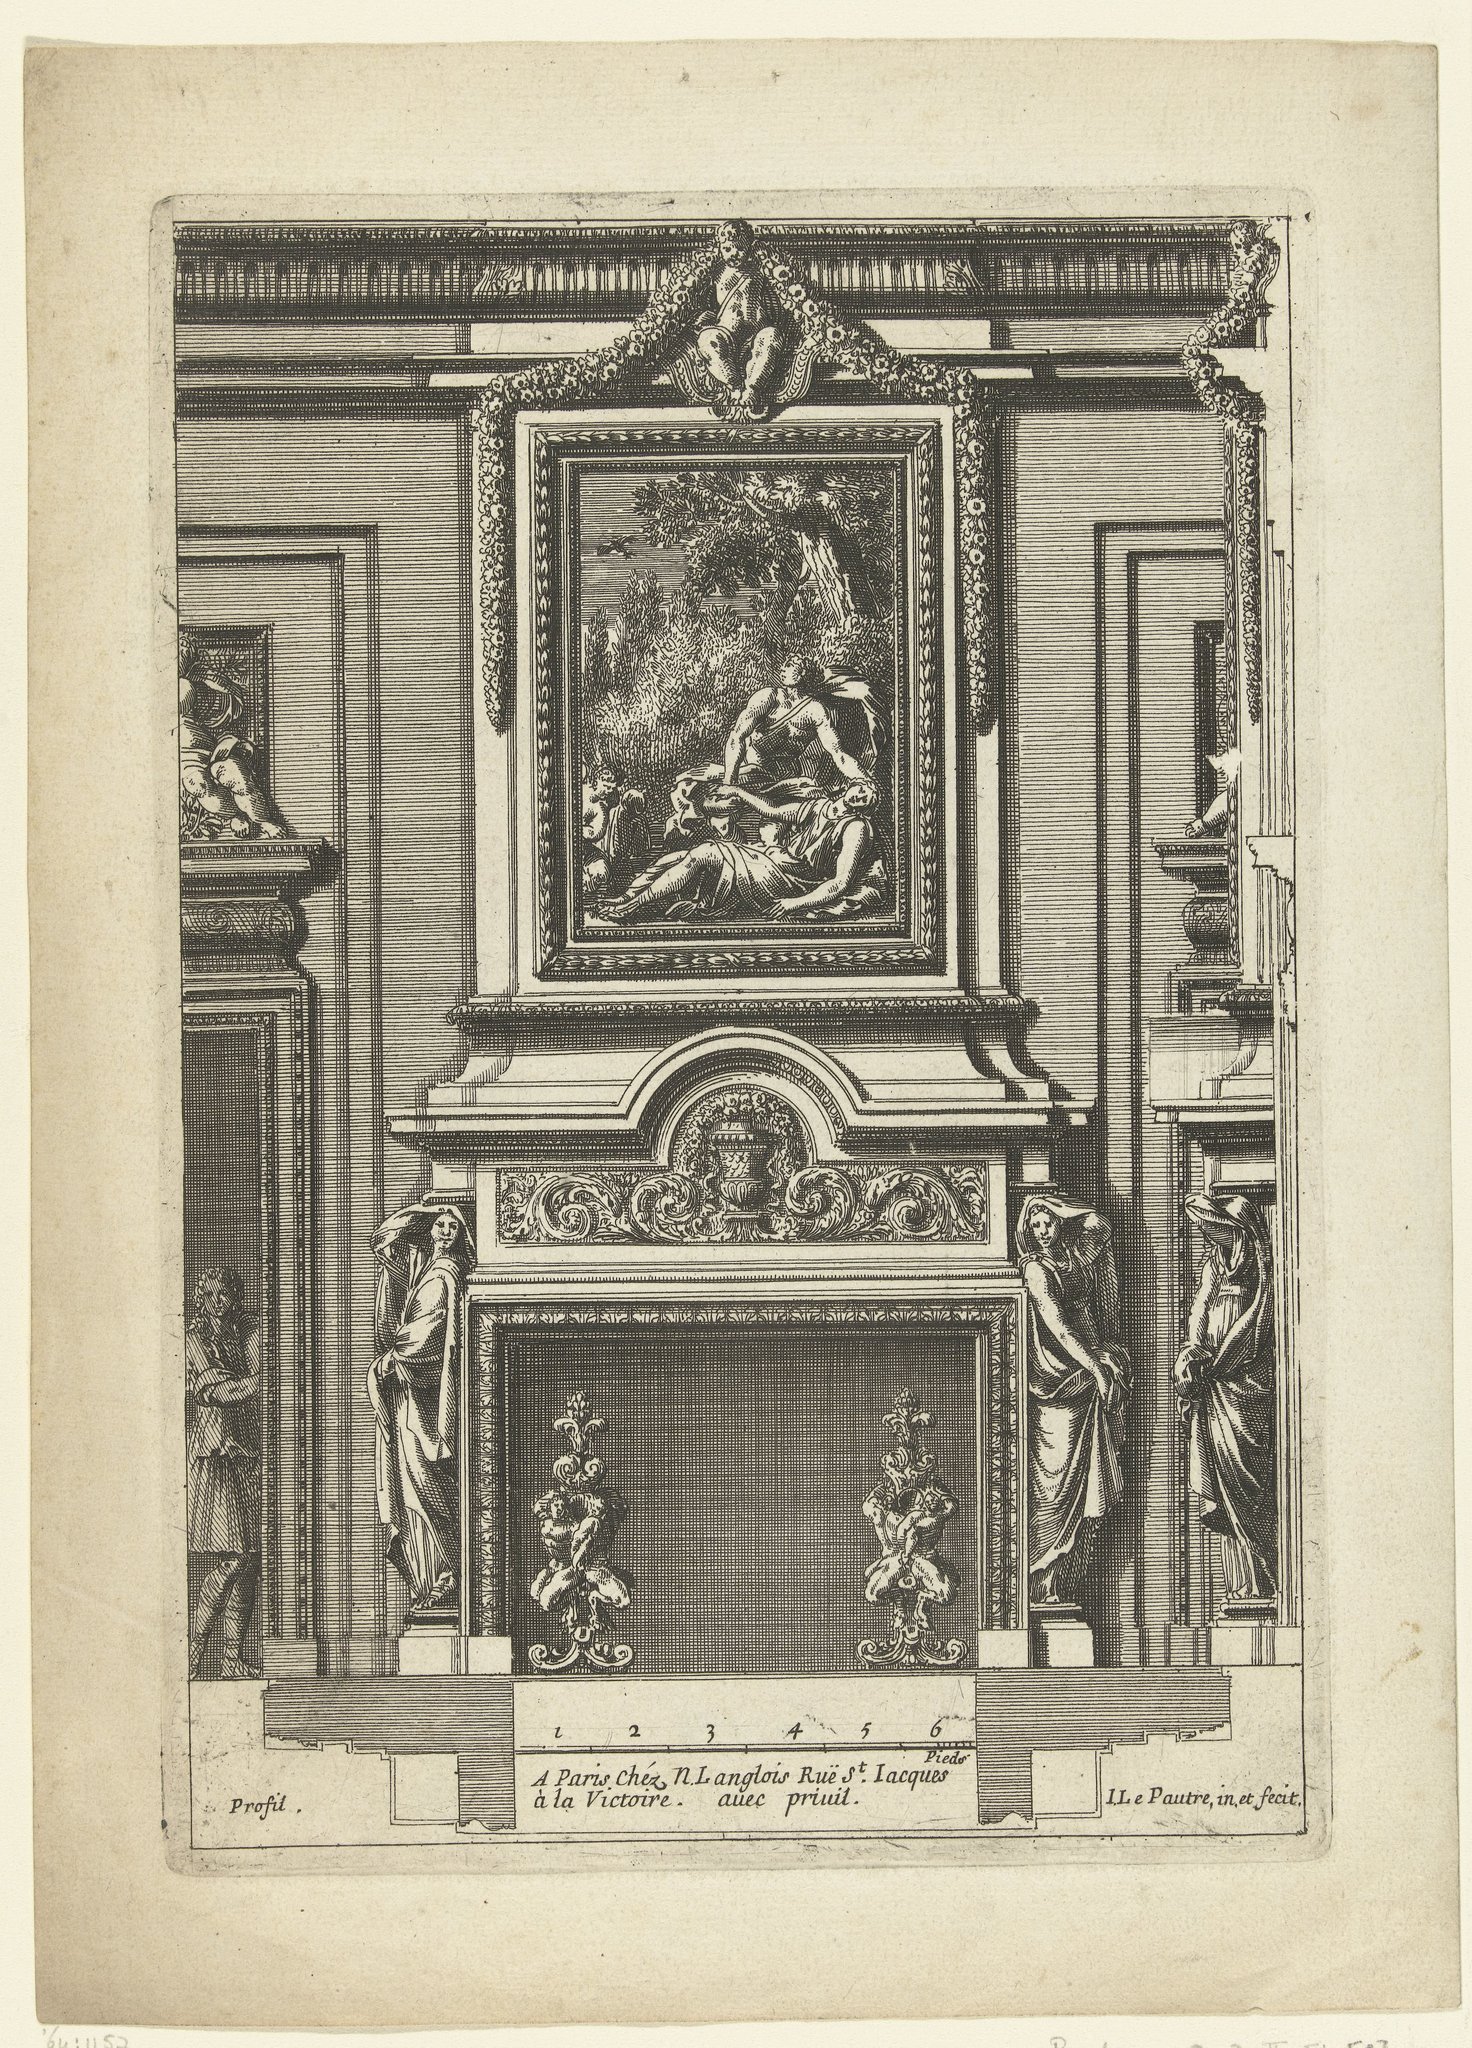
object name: print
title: Onderboezem met vierkant schilderij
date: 1665-1670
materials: paper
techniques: etching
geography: france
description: Op het schilderij staat de dood van Procris (?). Blad 4 uit serie van 6.